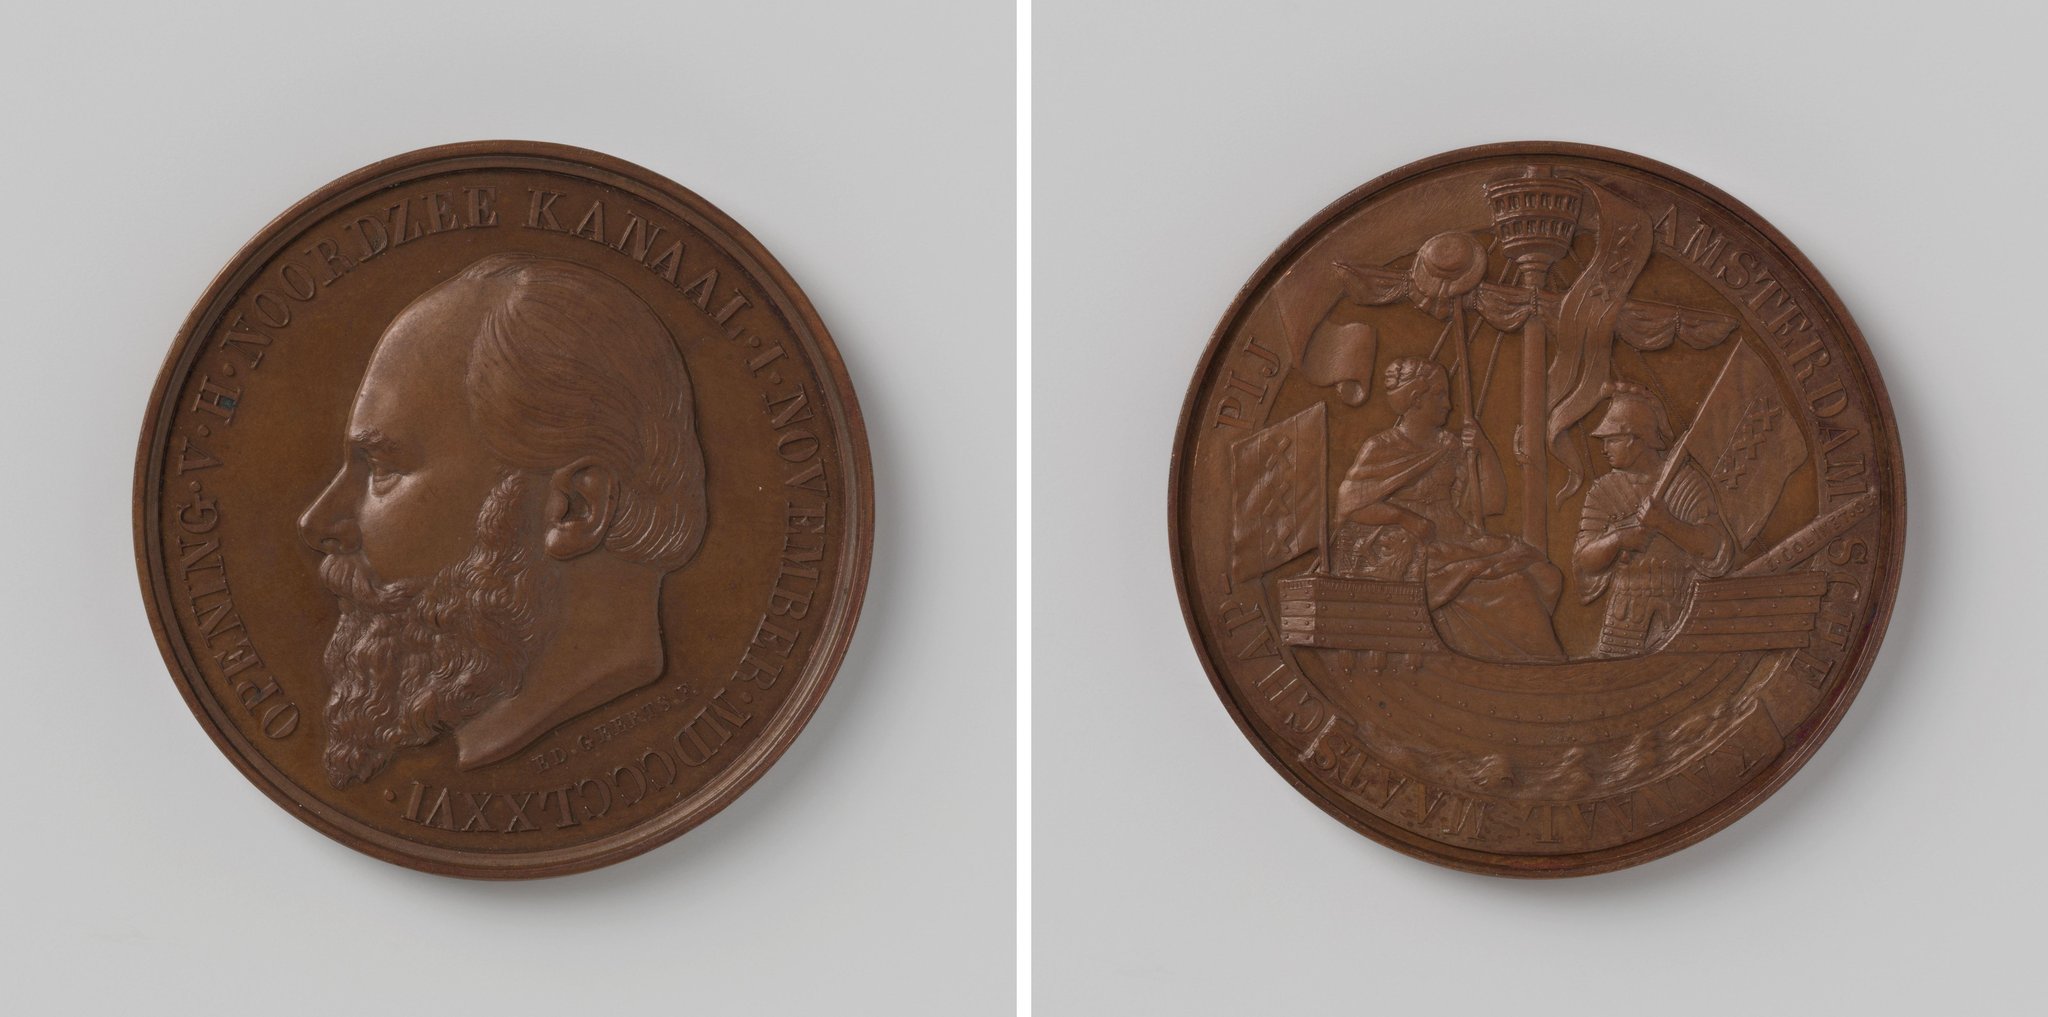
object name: history medal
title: Opening van het Noordzeekanaal, ter ere van Willem III, koning der Nederlanden, penning geslagen op last van de Amsterdamsche Kanaal Maatschappij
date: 1876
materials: bronze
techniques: striking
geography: brussels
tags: brussels, willem iii (koning der nederlanden)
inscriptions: signature: ‘ED. GEERTS . F.’, : ‘OPENING . V.H. NOORDZEEKANAAL . I . NOVEMBER . MDCCCLXXVI’, : ‘AMSTERDAMSCHE KANAAL MAATSCHAPPIJ’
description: Tweezijdige bronzen penning. Voorzijde: borststuk van Willem III binnen omschrift. Keerzijde: vrouw met vrijheidshoed op lans en gehelmde vrouw met vaandel, zittend in boot: het Amsterdamse koggeschip, binnen wimpel met opschrift.